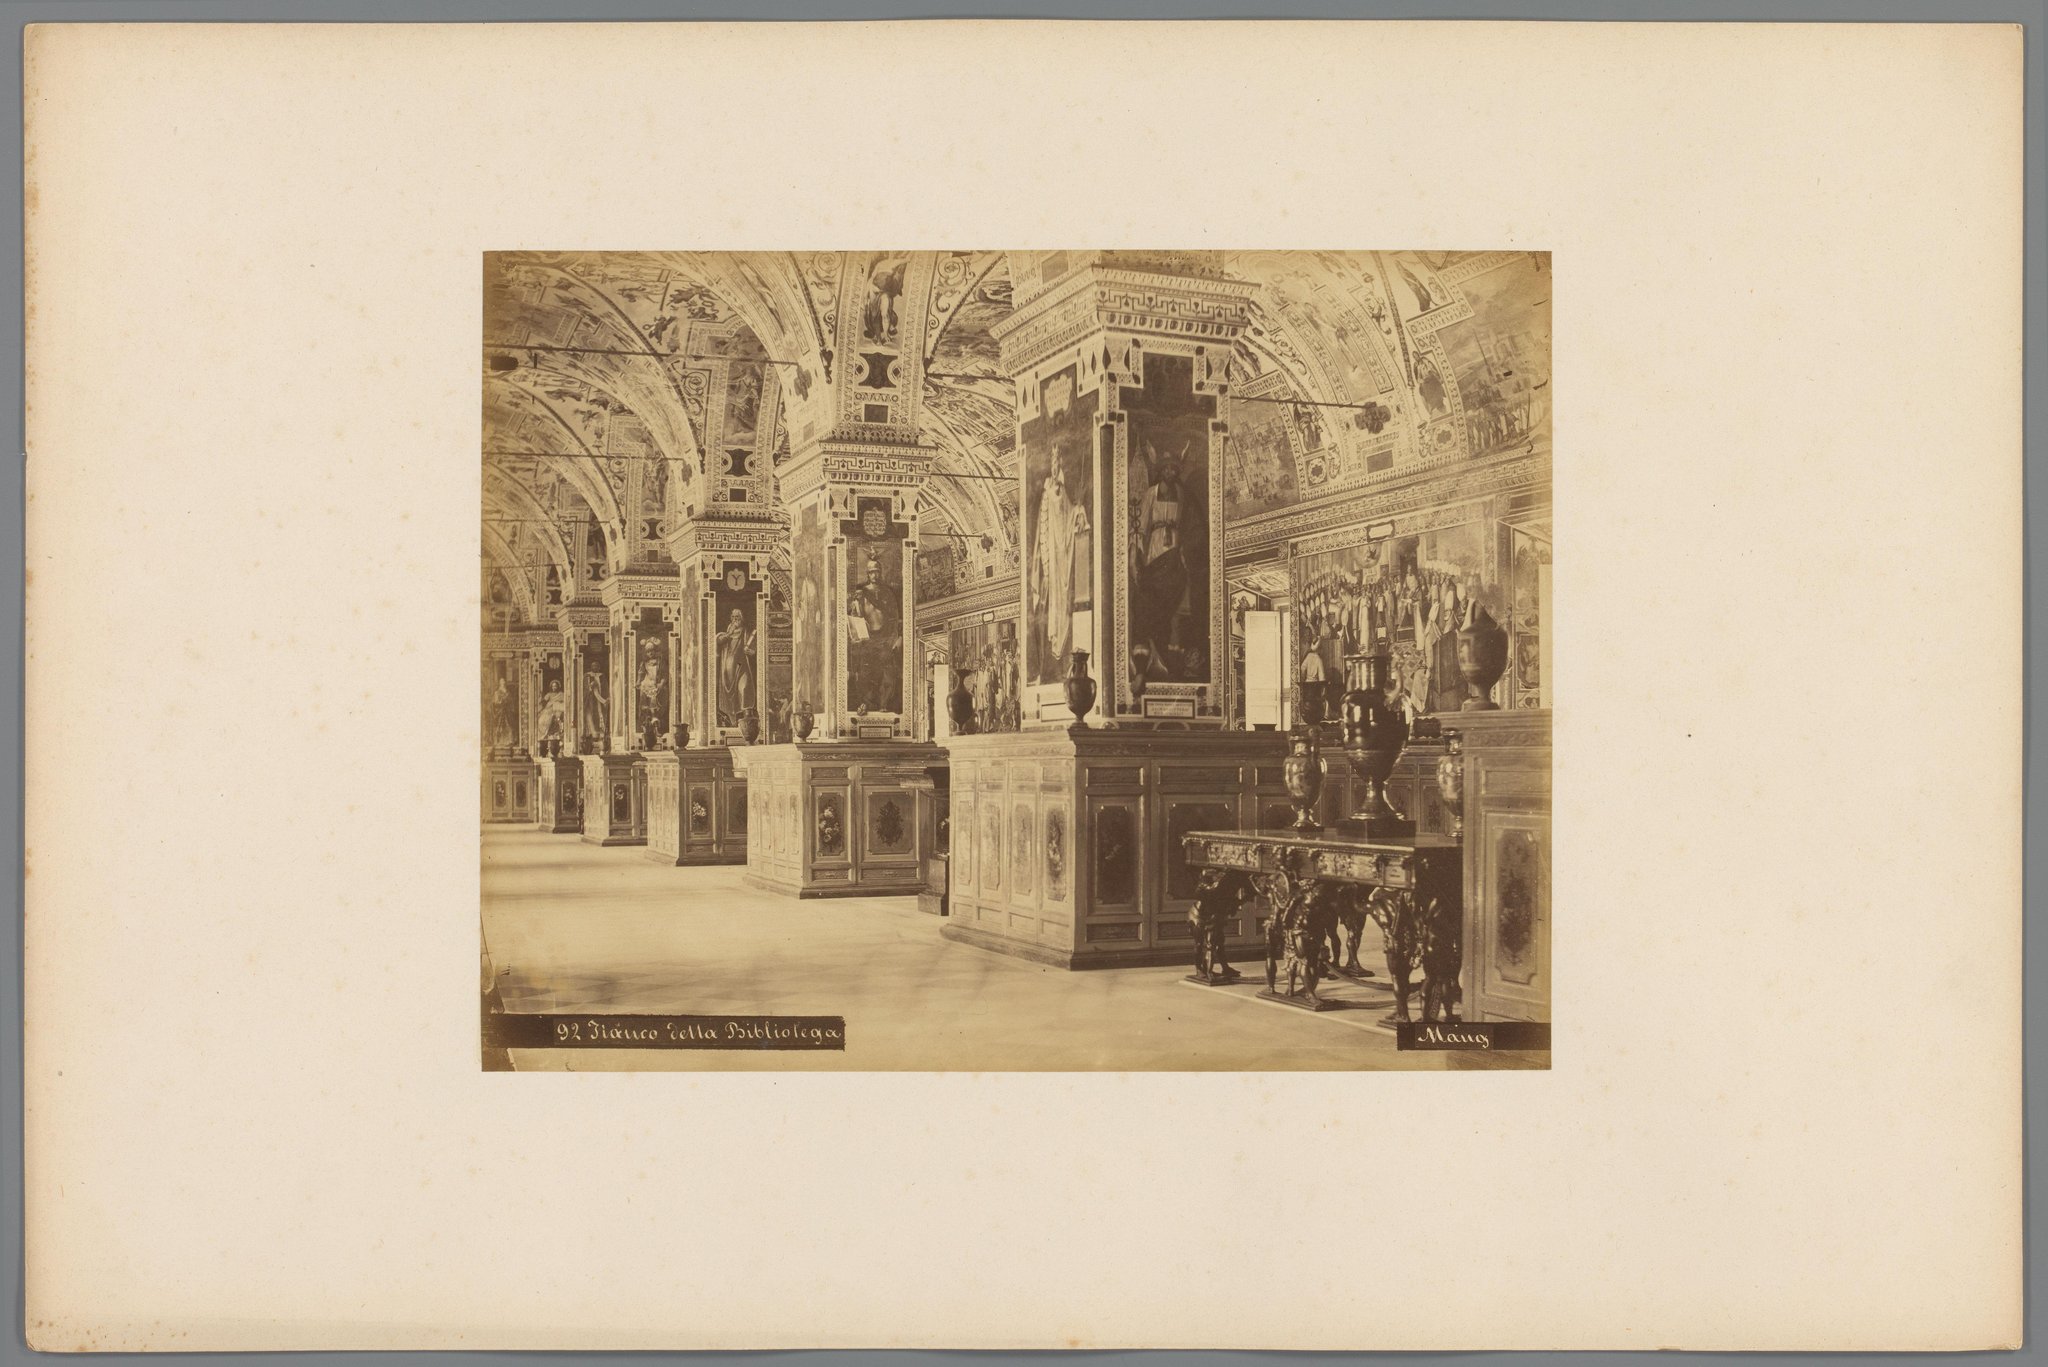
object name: photograph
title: Fianco della Bibliotega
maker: michèle mang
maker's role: fotograaf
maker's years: 1840-1909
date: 1863-1887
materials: cardboard, paper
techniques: albumen print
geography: vatican city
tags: interior ~ representation of a building, public library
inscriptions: number: ‘92’